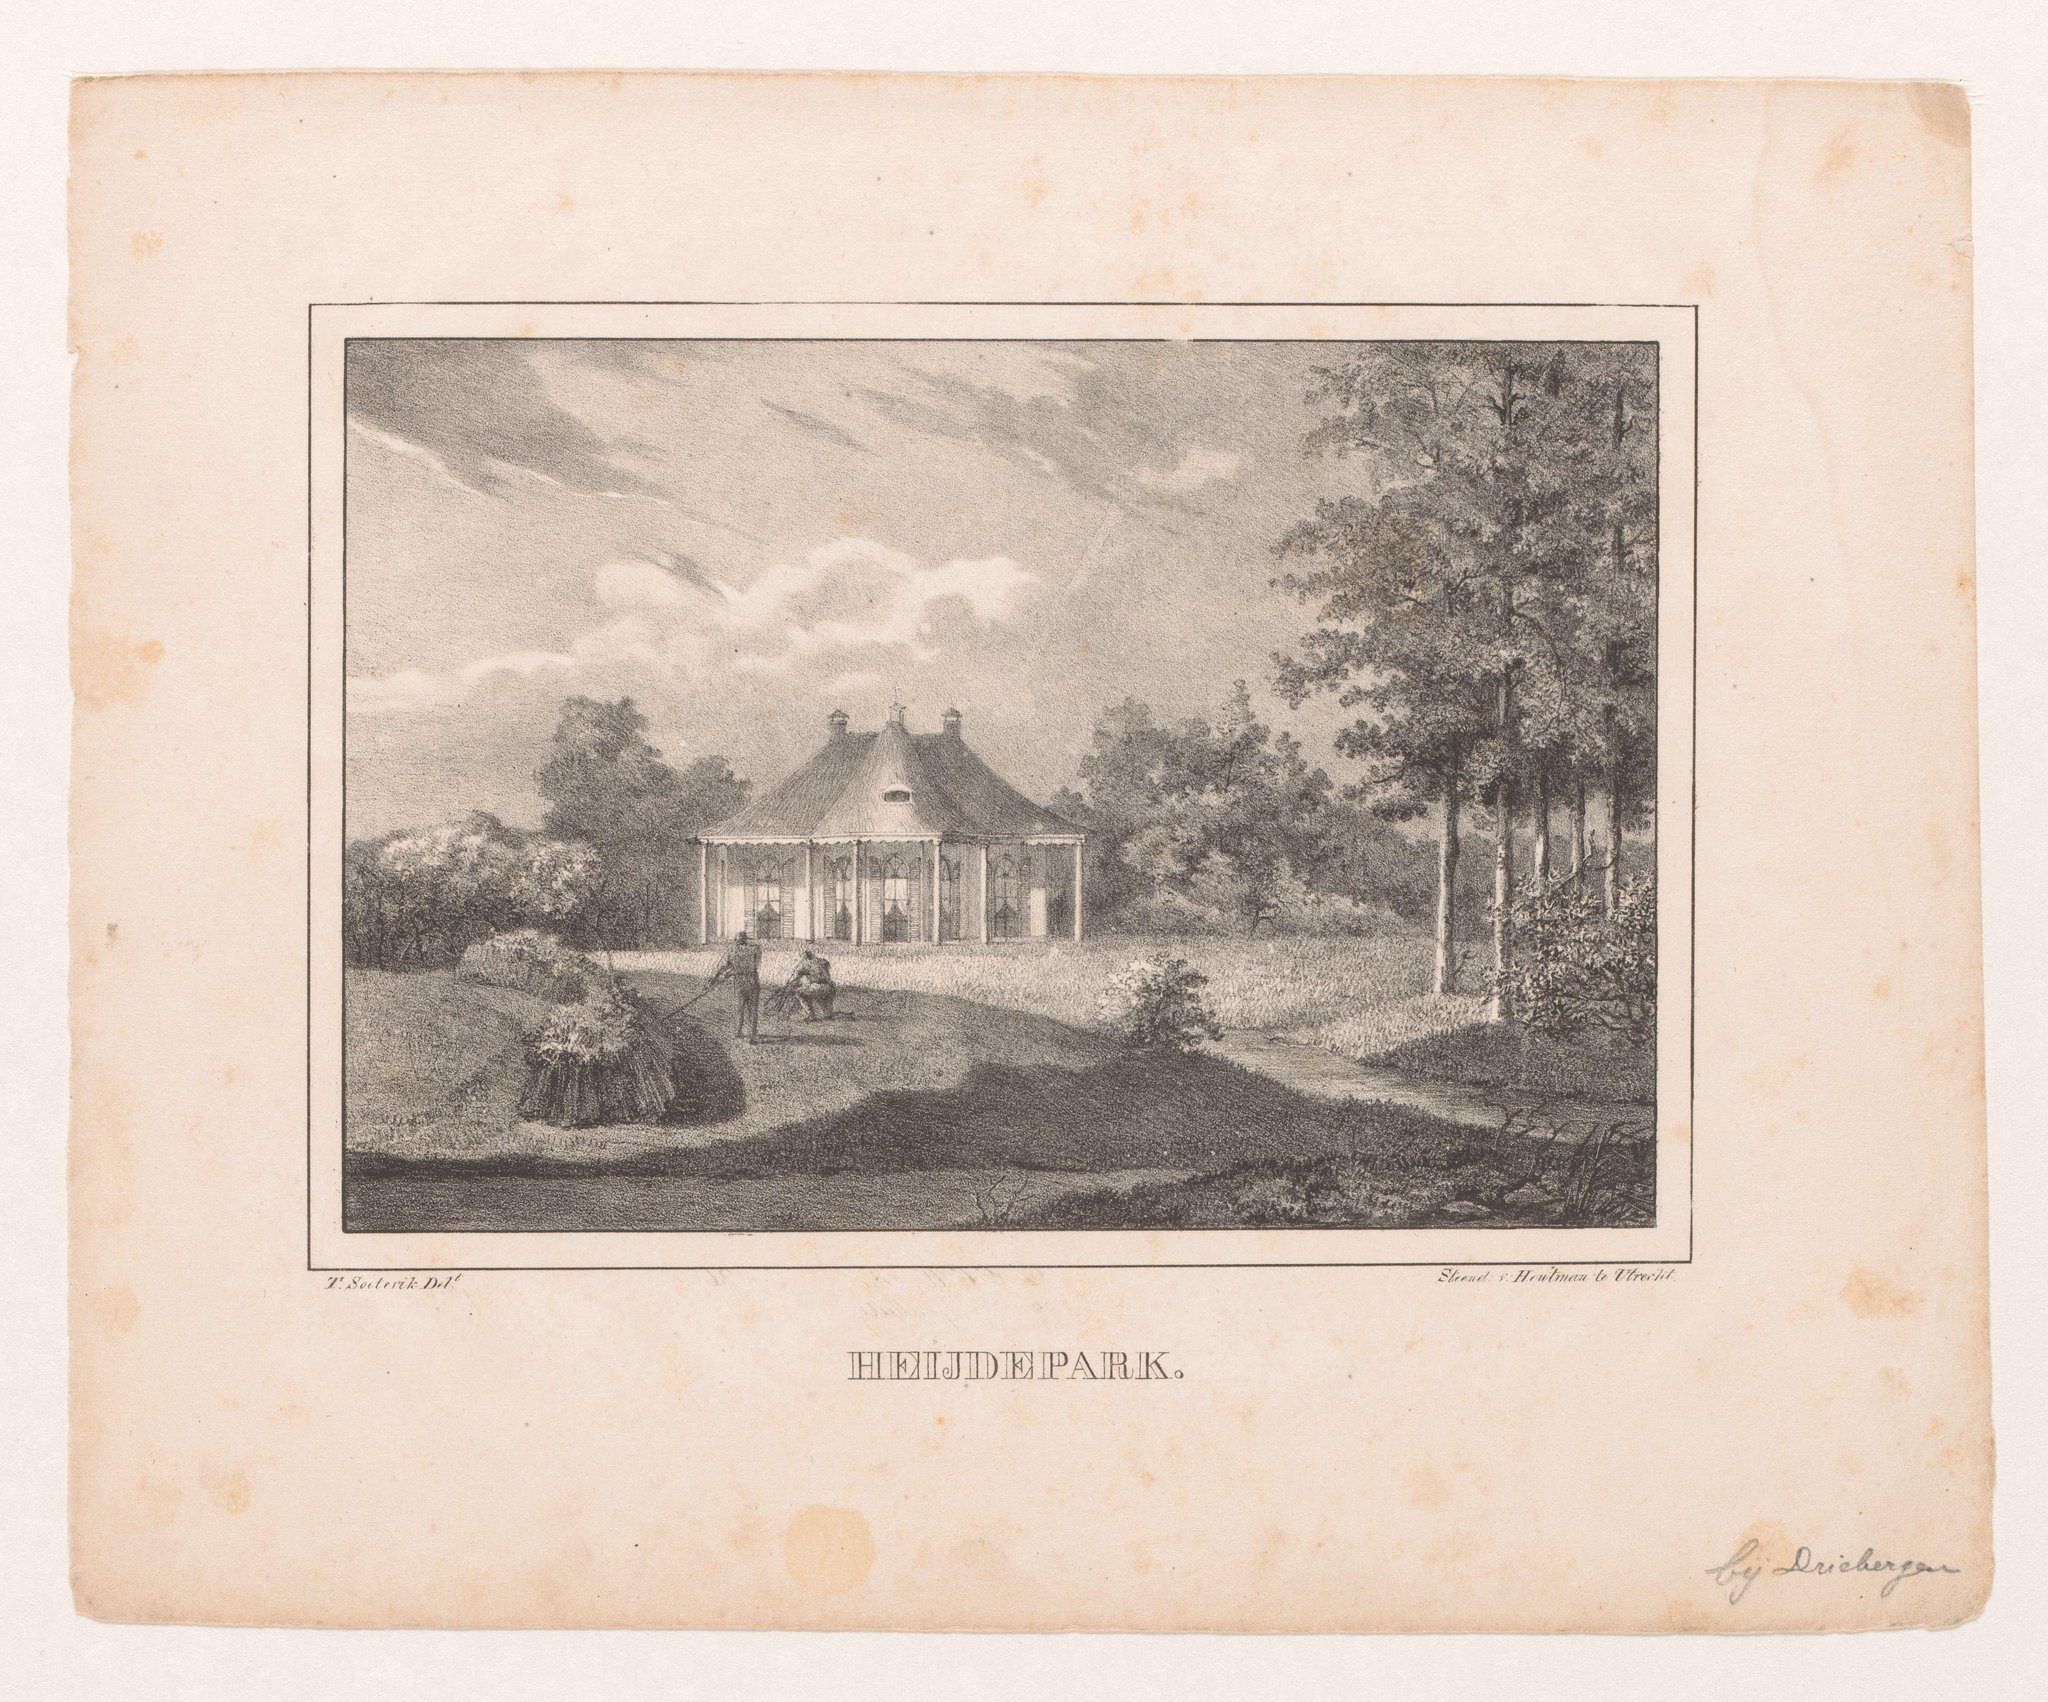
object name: print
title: Heijdepark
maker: johannes paulus houtman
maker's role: bookseller, print maker, printer, publisher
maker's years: 1803-1845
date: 1828-1830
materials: paper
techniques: lithograph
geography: utrecht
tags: villa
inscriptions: collector's mark: Lugt 2228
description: Prent uit: Mourot, M. Gezigten van buitenplaatsen en gebouwen gelegen tusschen de stad Utrecht en de Grebbe. Utrecht: Houtman, Johannes Paulus, 1828-1830.